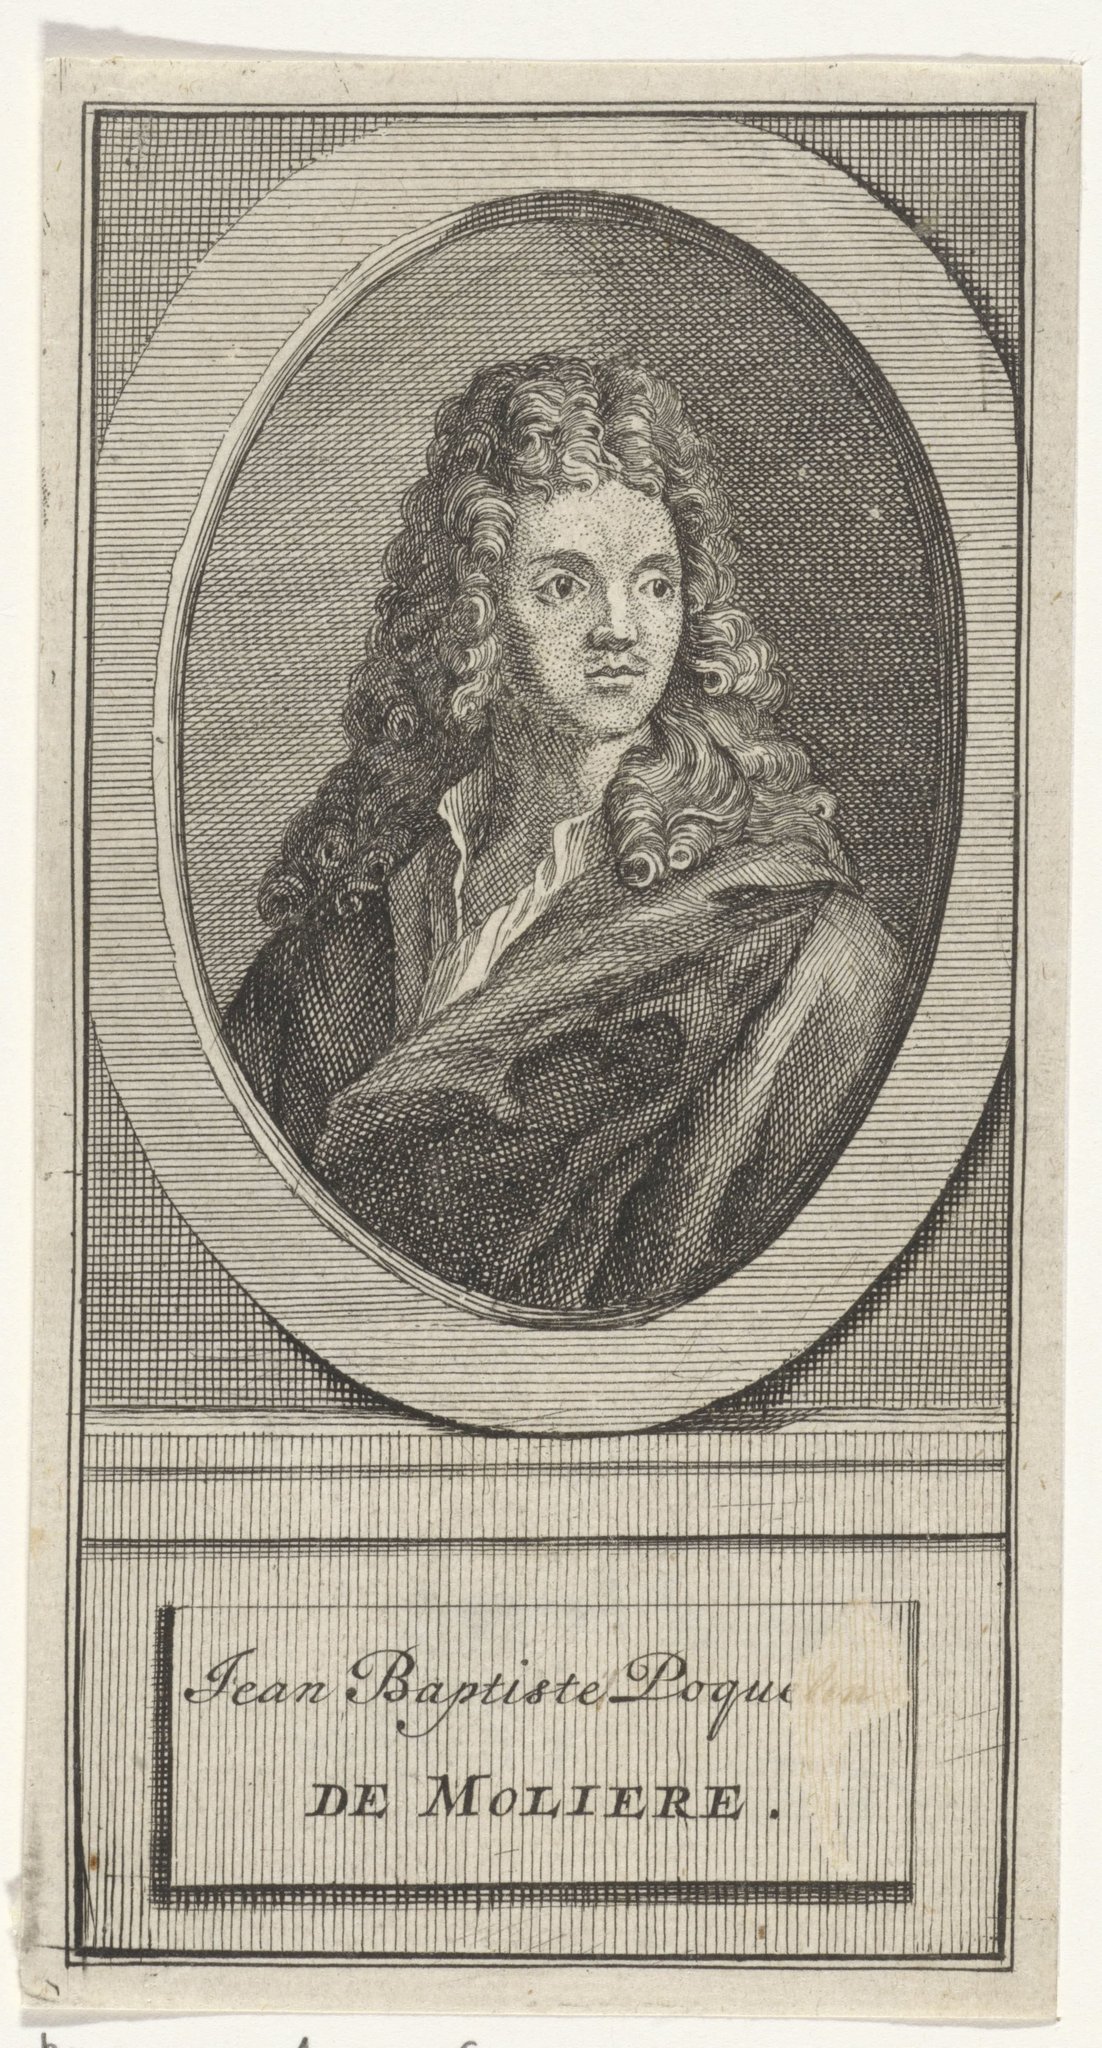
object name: print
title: Portret van Jean Baptiste Poquelin Molière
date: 1705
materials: paper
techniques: etching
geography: amsterdam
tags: paris, jean baptiste poquelin molière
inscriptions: collector's mark: Lugt 2228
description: Illustratie in: Grimarest, Jean Léonor le Gallois de. Het leven van J:B: Poquelin de Moljere, beroemd Frans tooneel-speelder. Amsterdam: Nicolaas ten Hoorn, 1705.